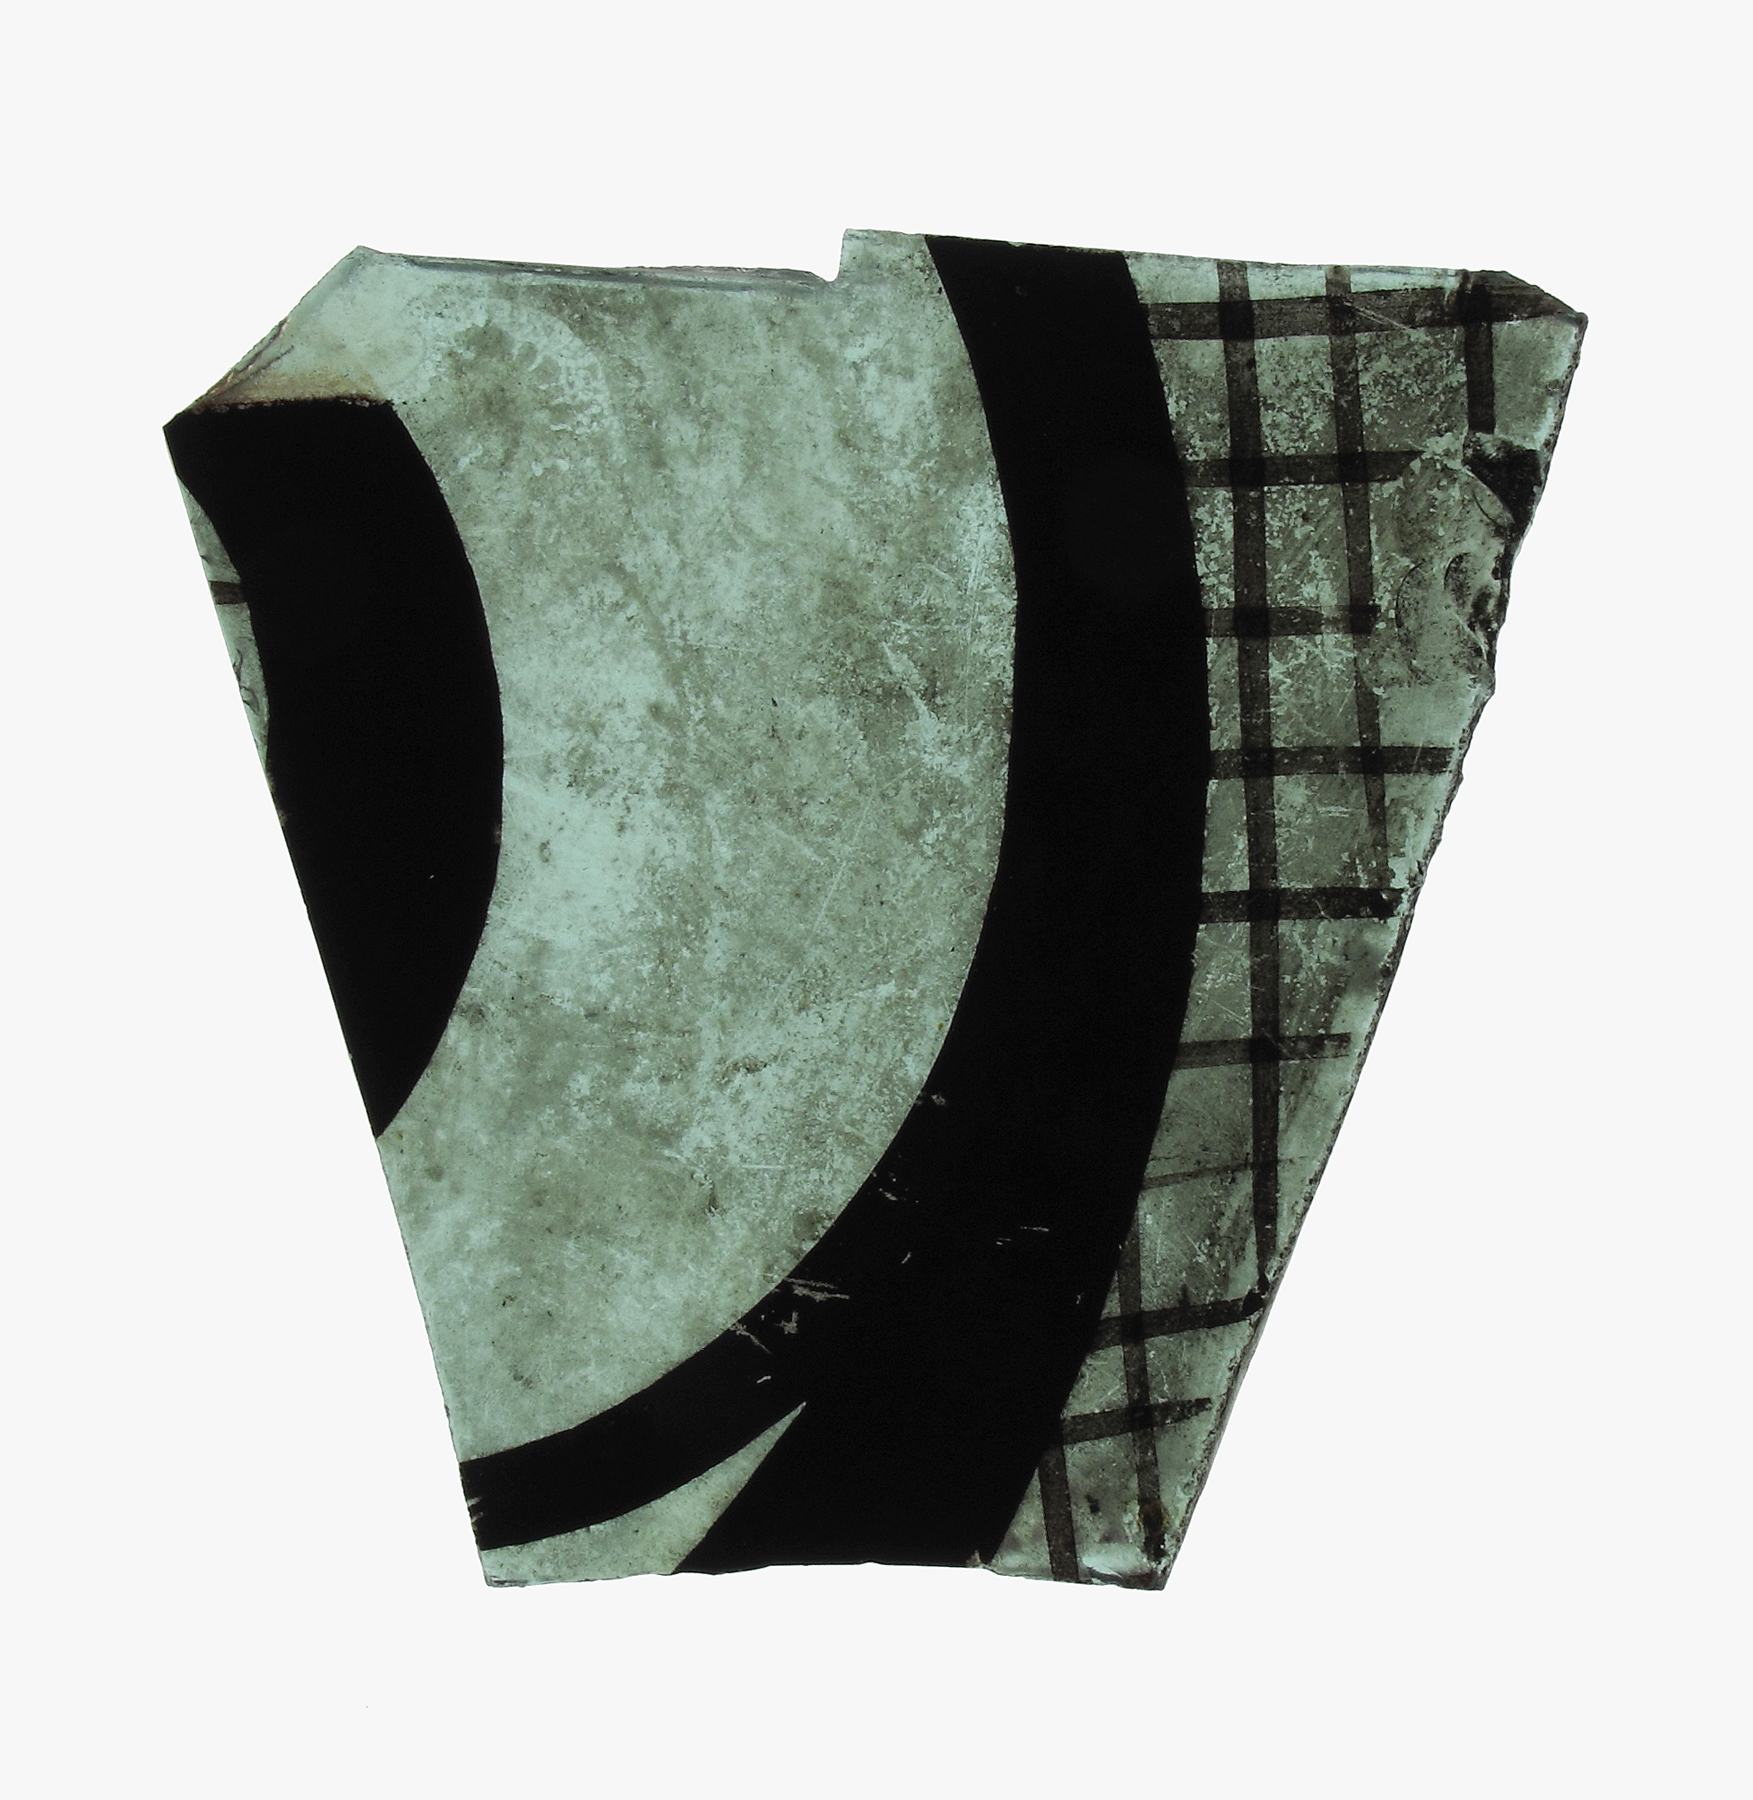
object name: fragment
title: Glass Fragment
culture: french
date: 1201-1300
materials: glass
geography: france